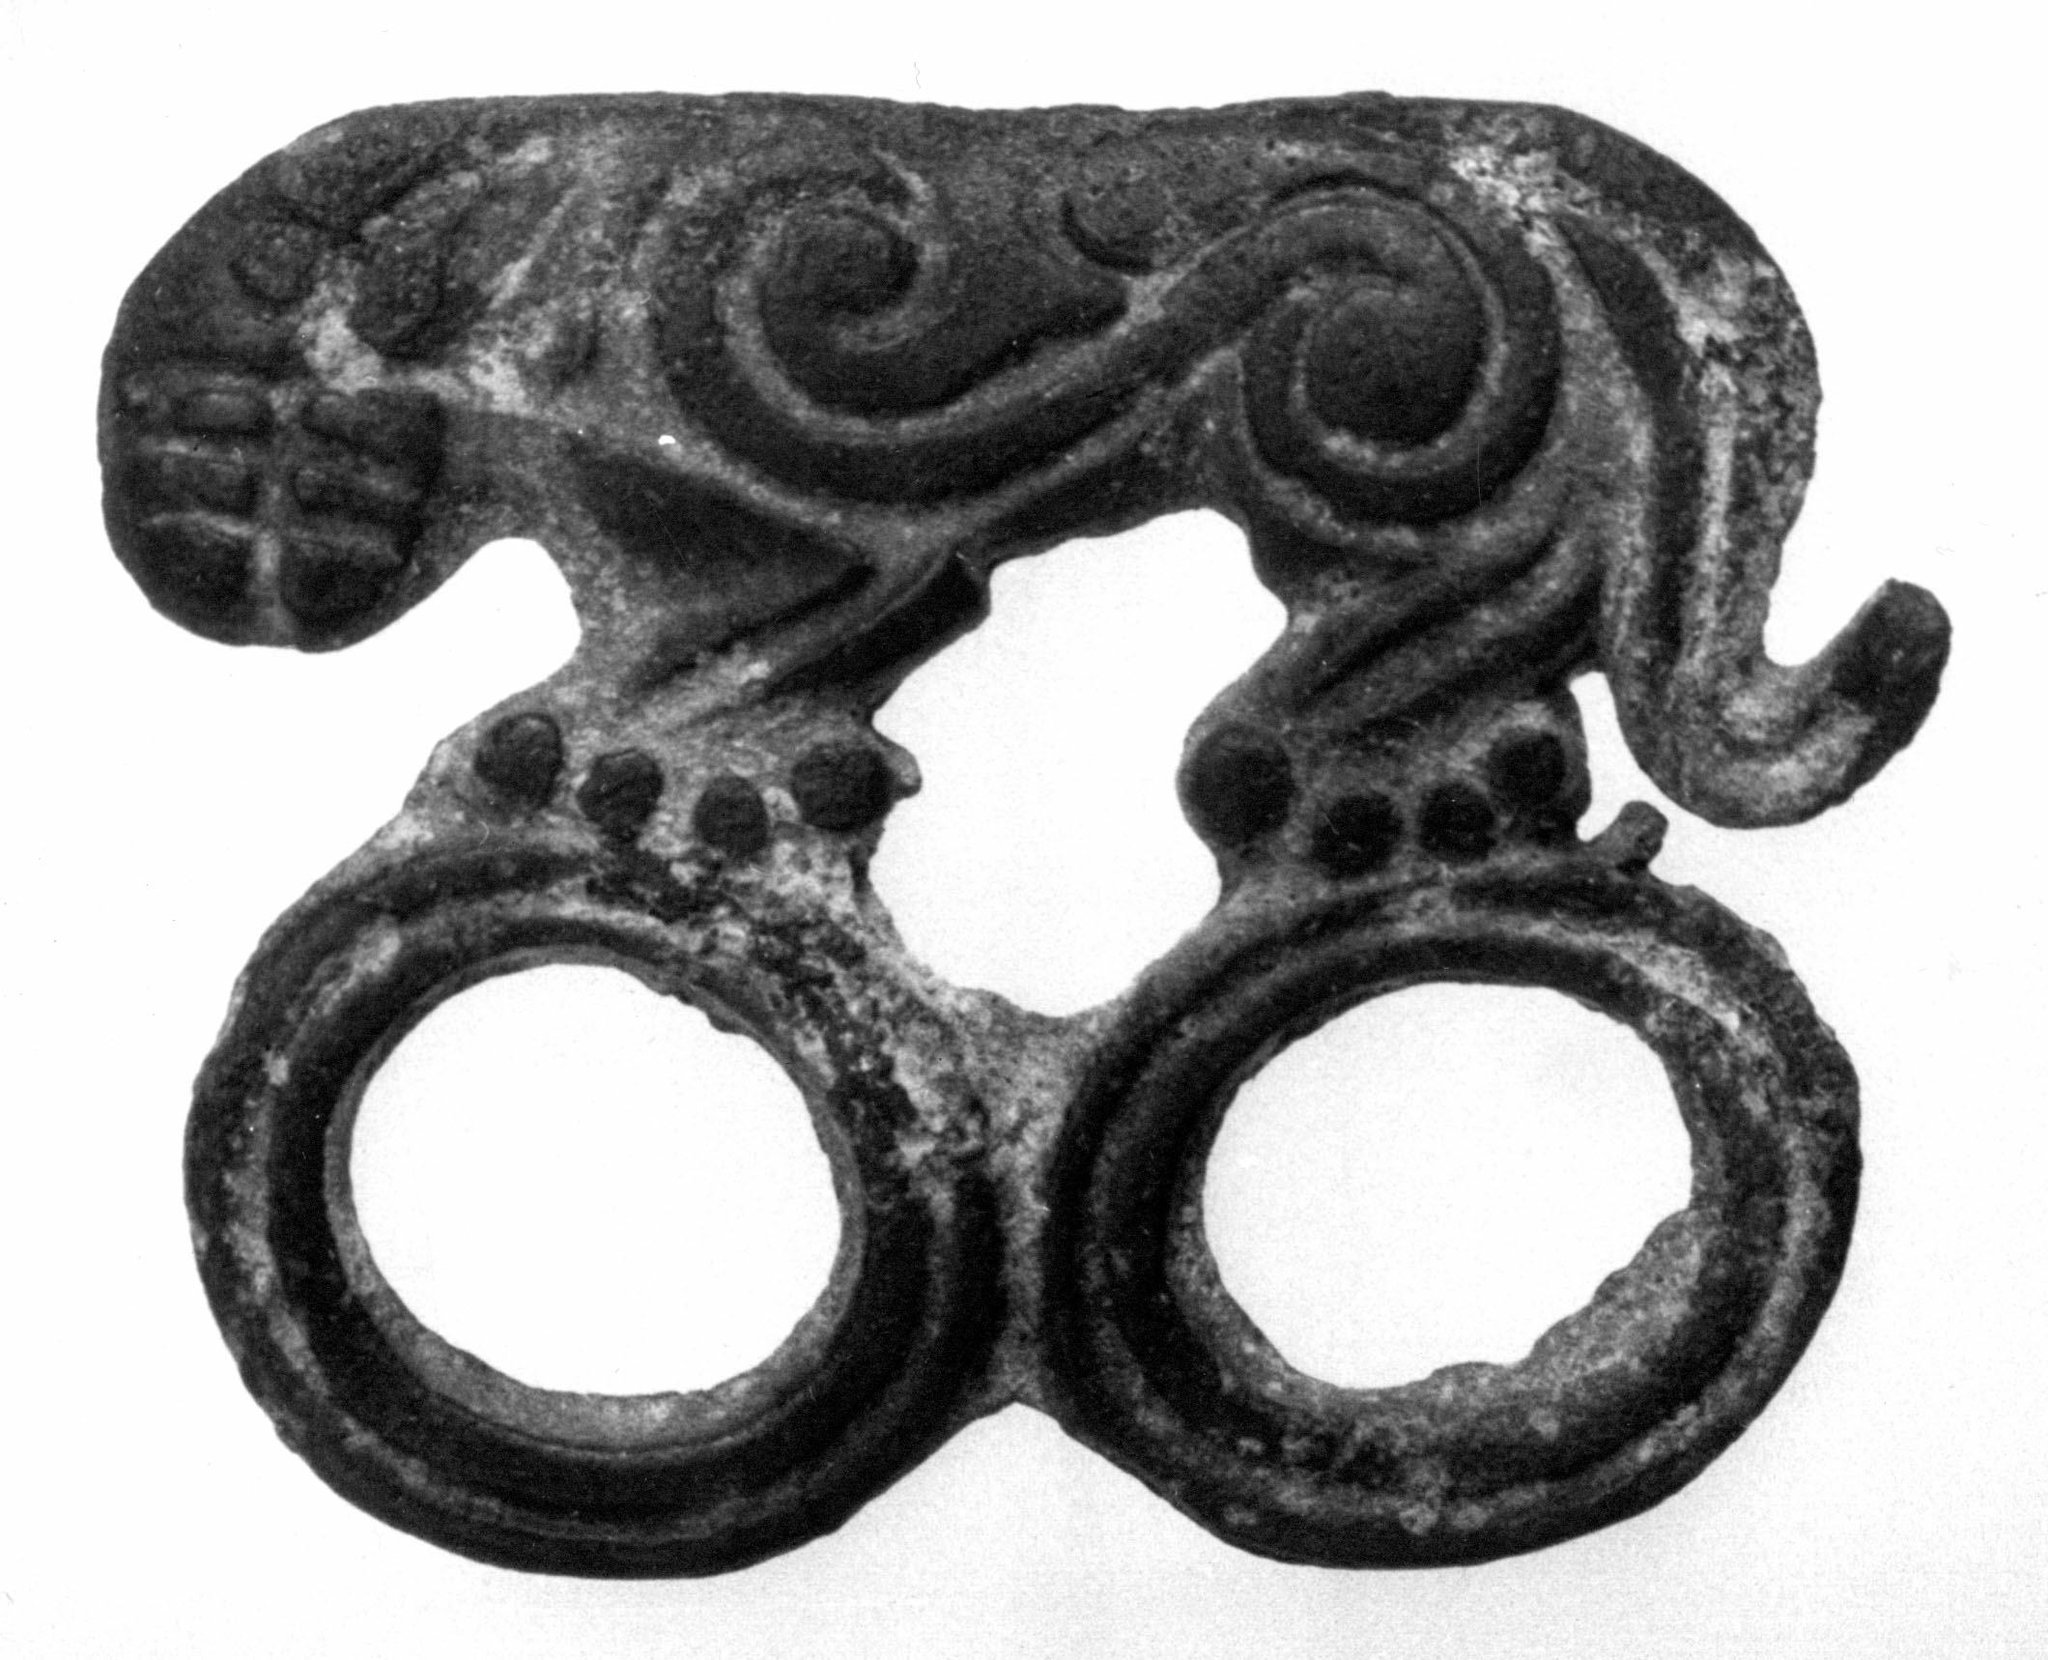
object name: buckle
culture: chinese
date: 300-201 BCE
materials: bronze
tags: animals